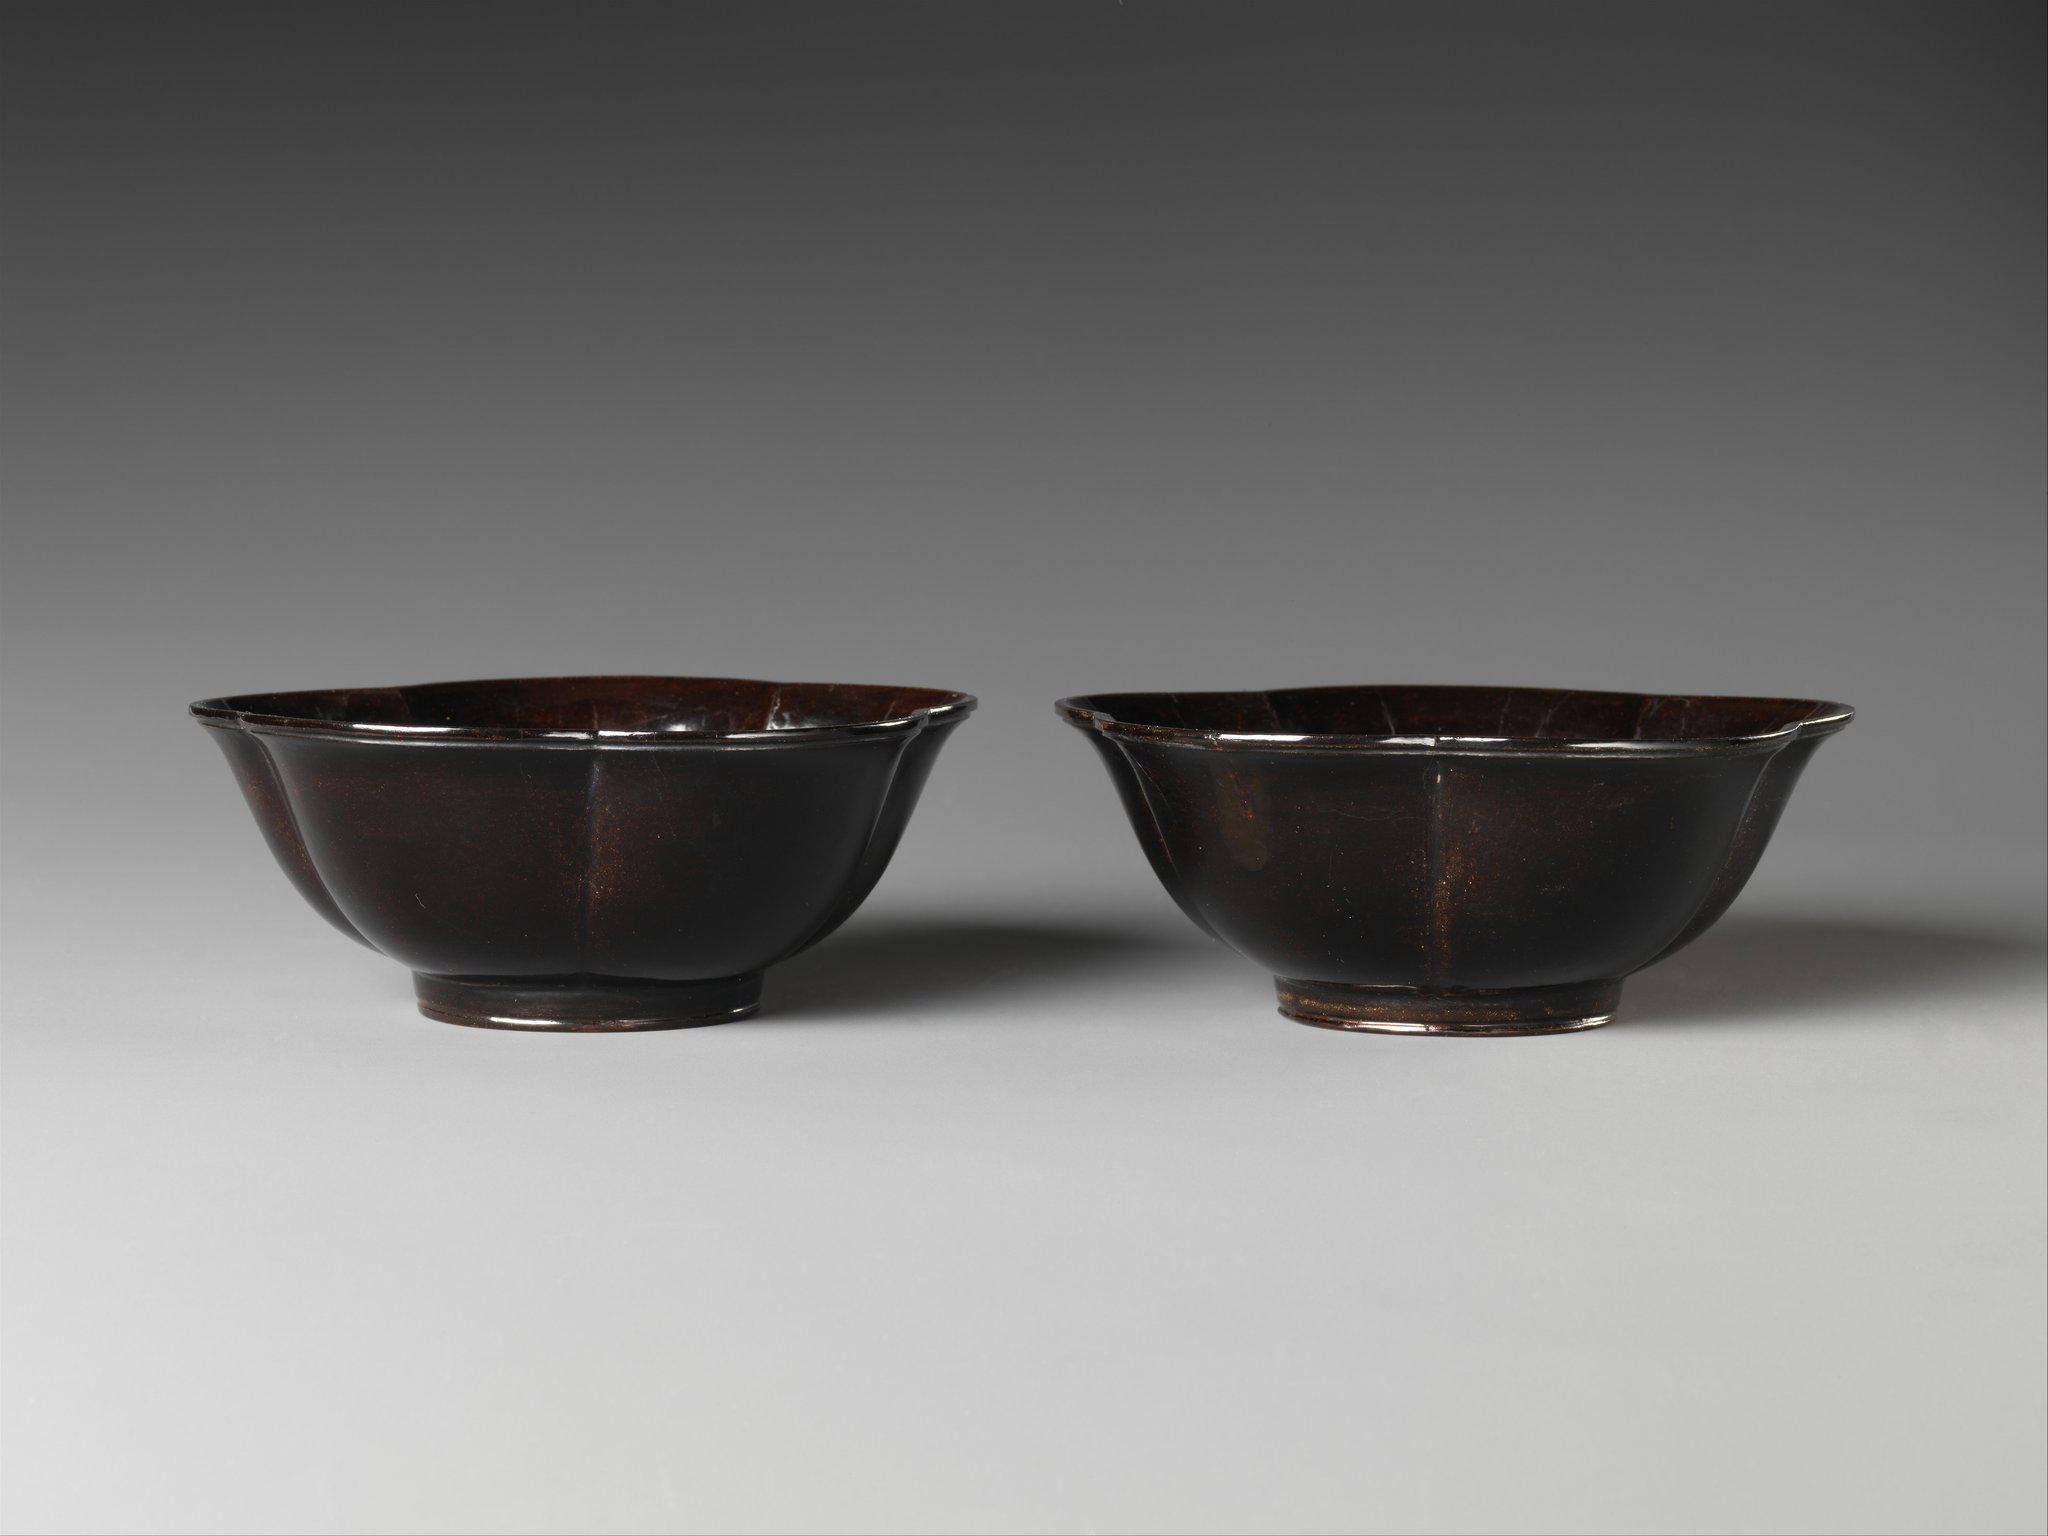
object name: cup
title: Pair of plum-blossom-shaped cups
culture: chinese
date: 1001-1200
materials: lacquer